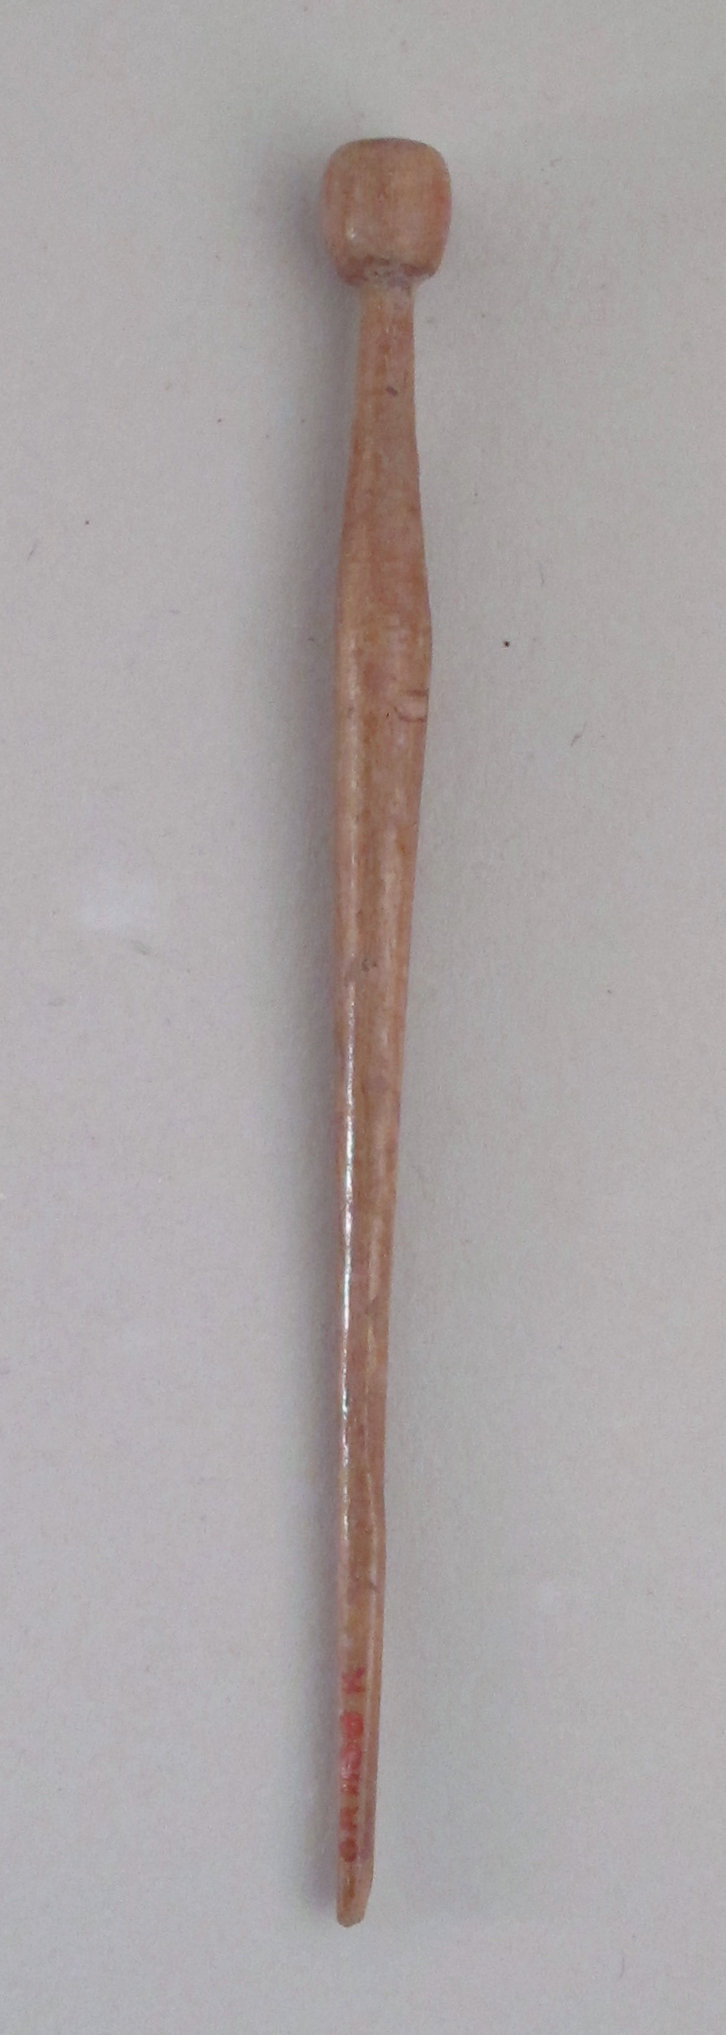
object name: stylus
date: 7000 BCE-330 CE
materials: bone, ivory